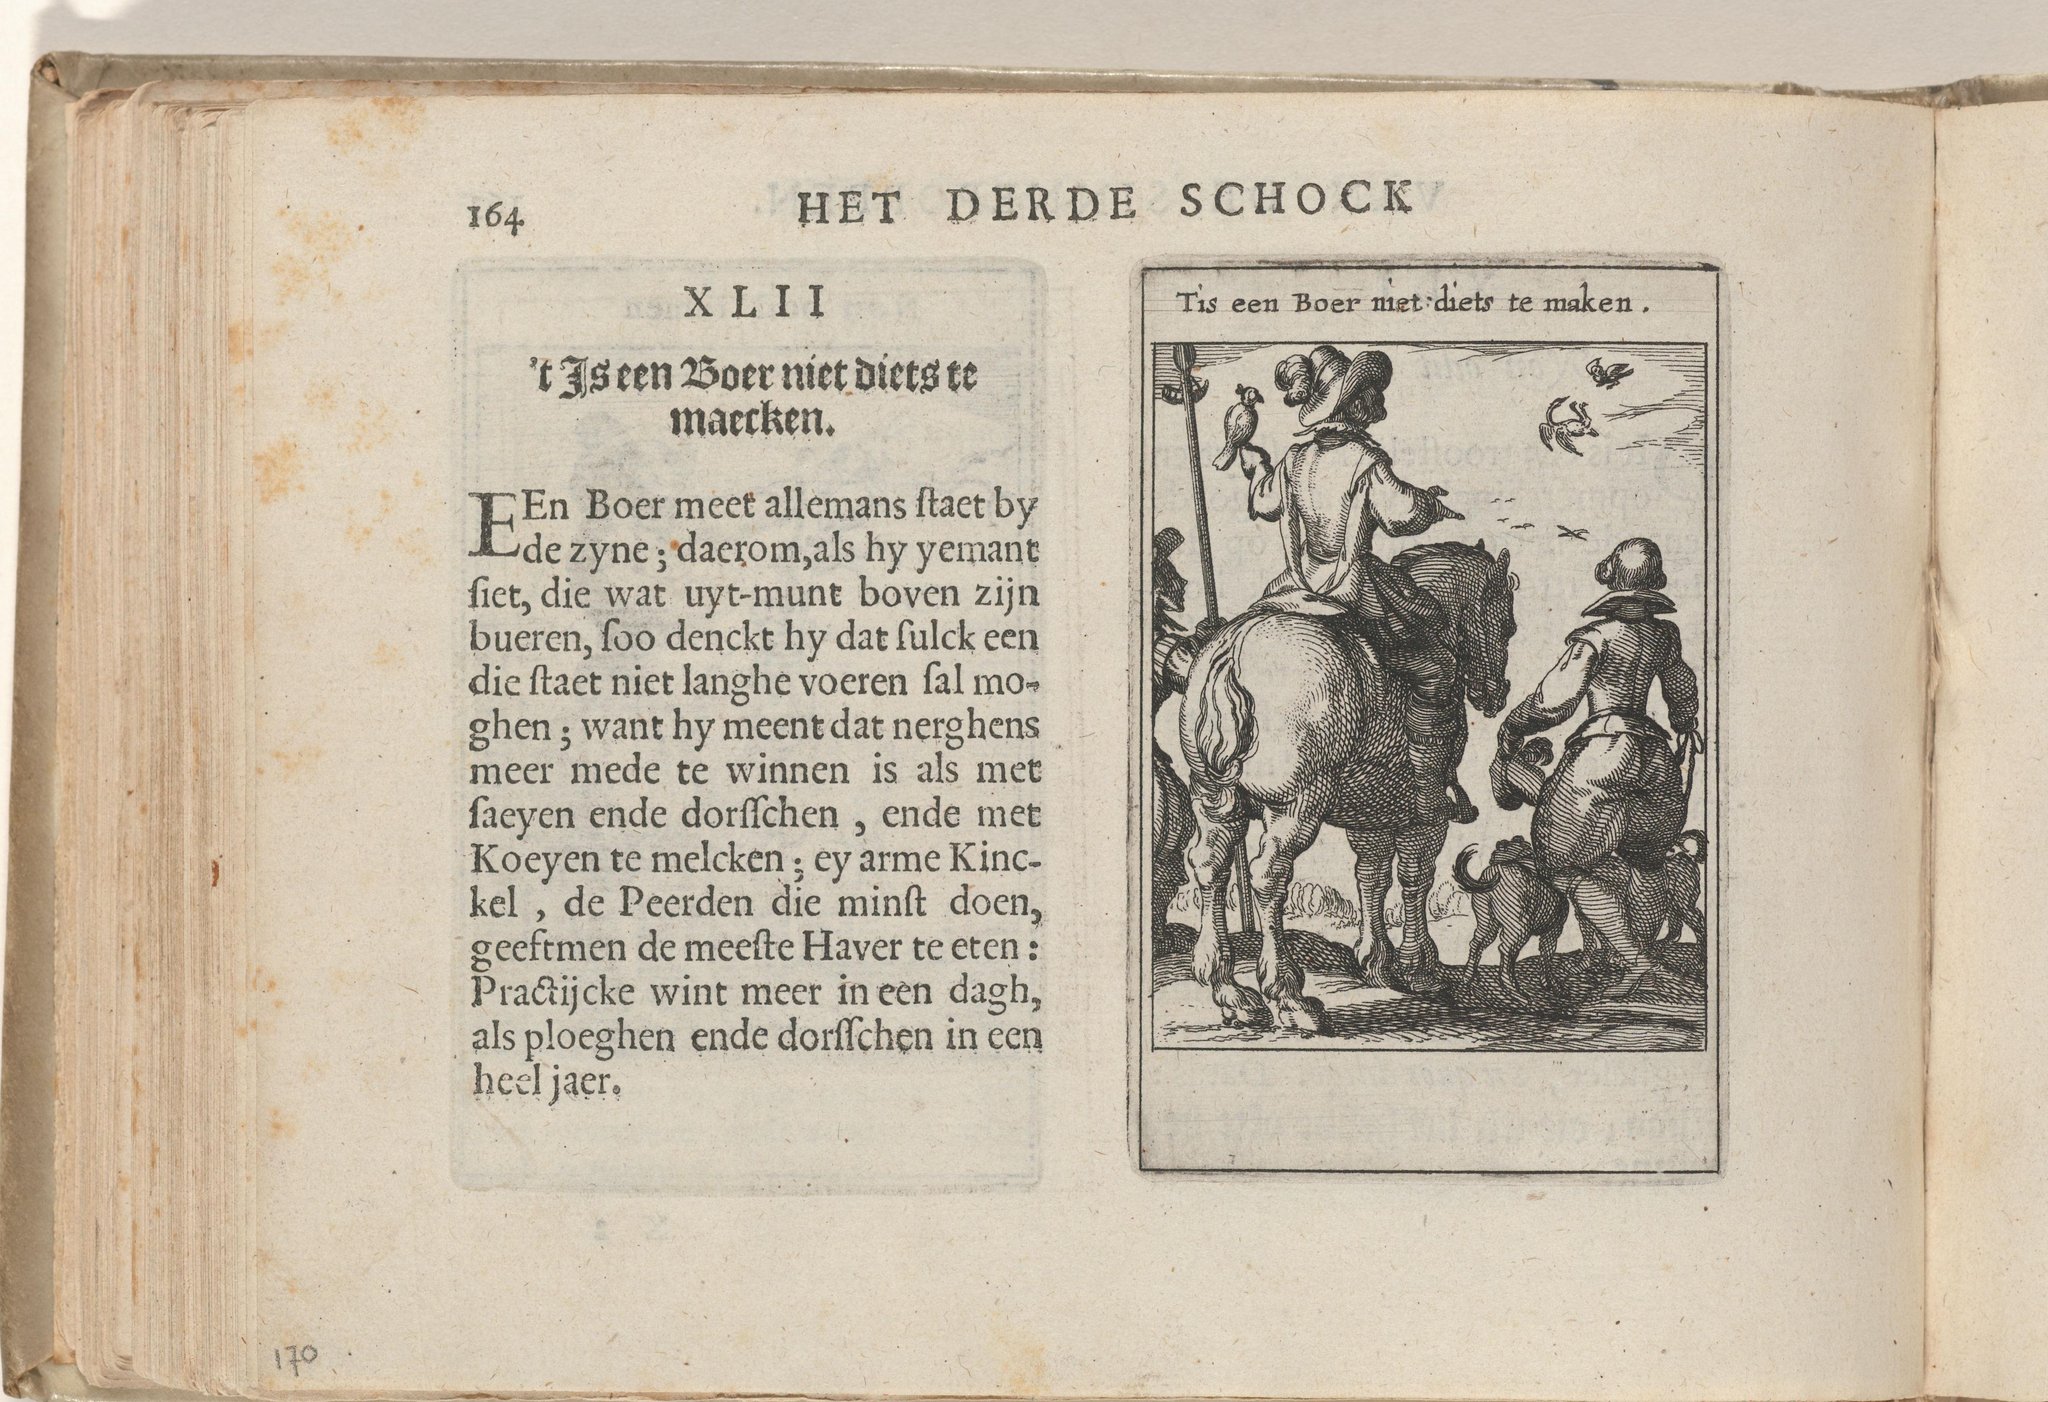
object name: print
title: XLII Tis een Boer niet diets te maken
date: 1614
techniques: engraving, printing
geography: the hague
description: XLII Tis een Boer niet diets te maken. Derde schok. Onderdeel van 'Sinnepoppen', R. Visscher, 1614.